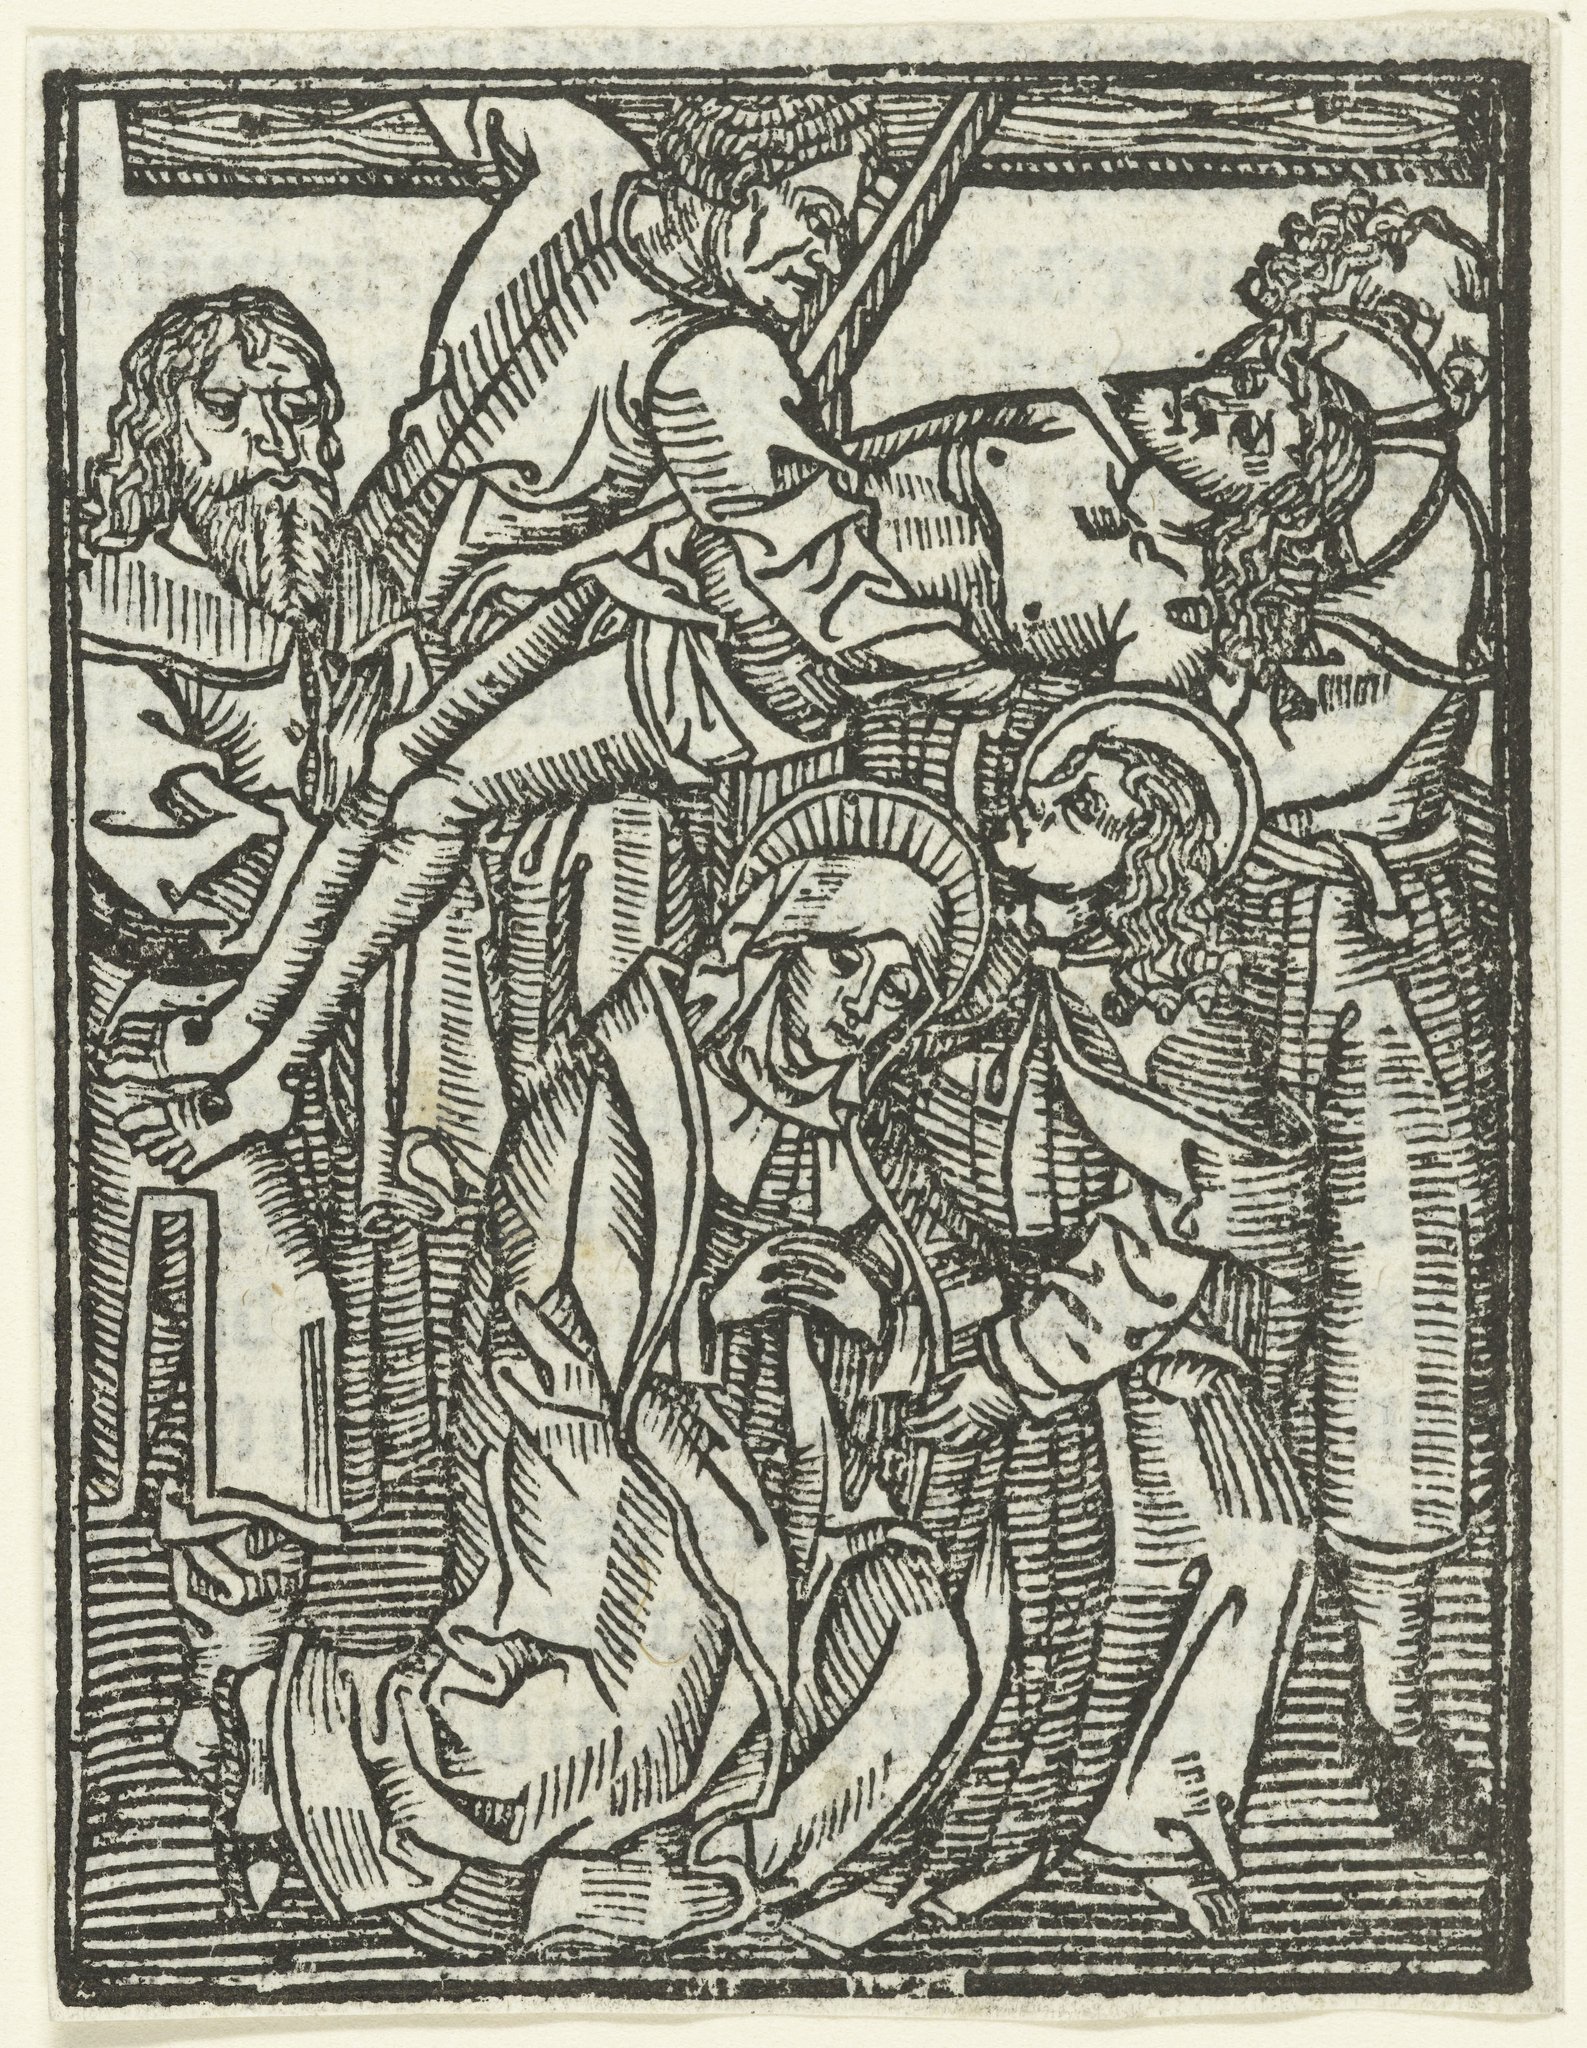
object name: book illustration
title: De kruisafname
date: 1490-1500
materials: paper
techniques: woodcut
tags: descent from the cross: christ is taken down from the cross, usually by nicodemus and joseph of arimathaea who are standing on the ladders (both arms of christ detached)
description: Eén blad van 113 uit Ludolphus de Saxonia, "Dit es dleué ons liefs heeren ihesu christi". Anonieme Nederlandse vertaling. Uitgegeven door Henrick Eckert van Homberch te Antwerpen in 1503. Botke, K. Deze 113 houtsneden, die meestal reeds in vroege Nederlandse boeken gebruikt zijn, worden toegeschreven aan de tweede Meester van Delft, de Meester van de Delbecq-Schreiber-passie en de Meester van de Virgo inter Virgines. In Conway (1884) en in "De gulden passer"(1951) zijn tevens eerdere versies opgenomen. Botke, K.